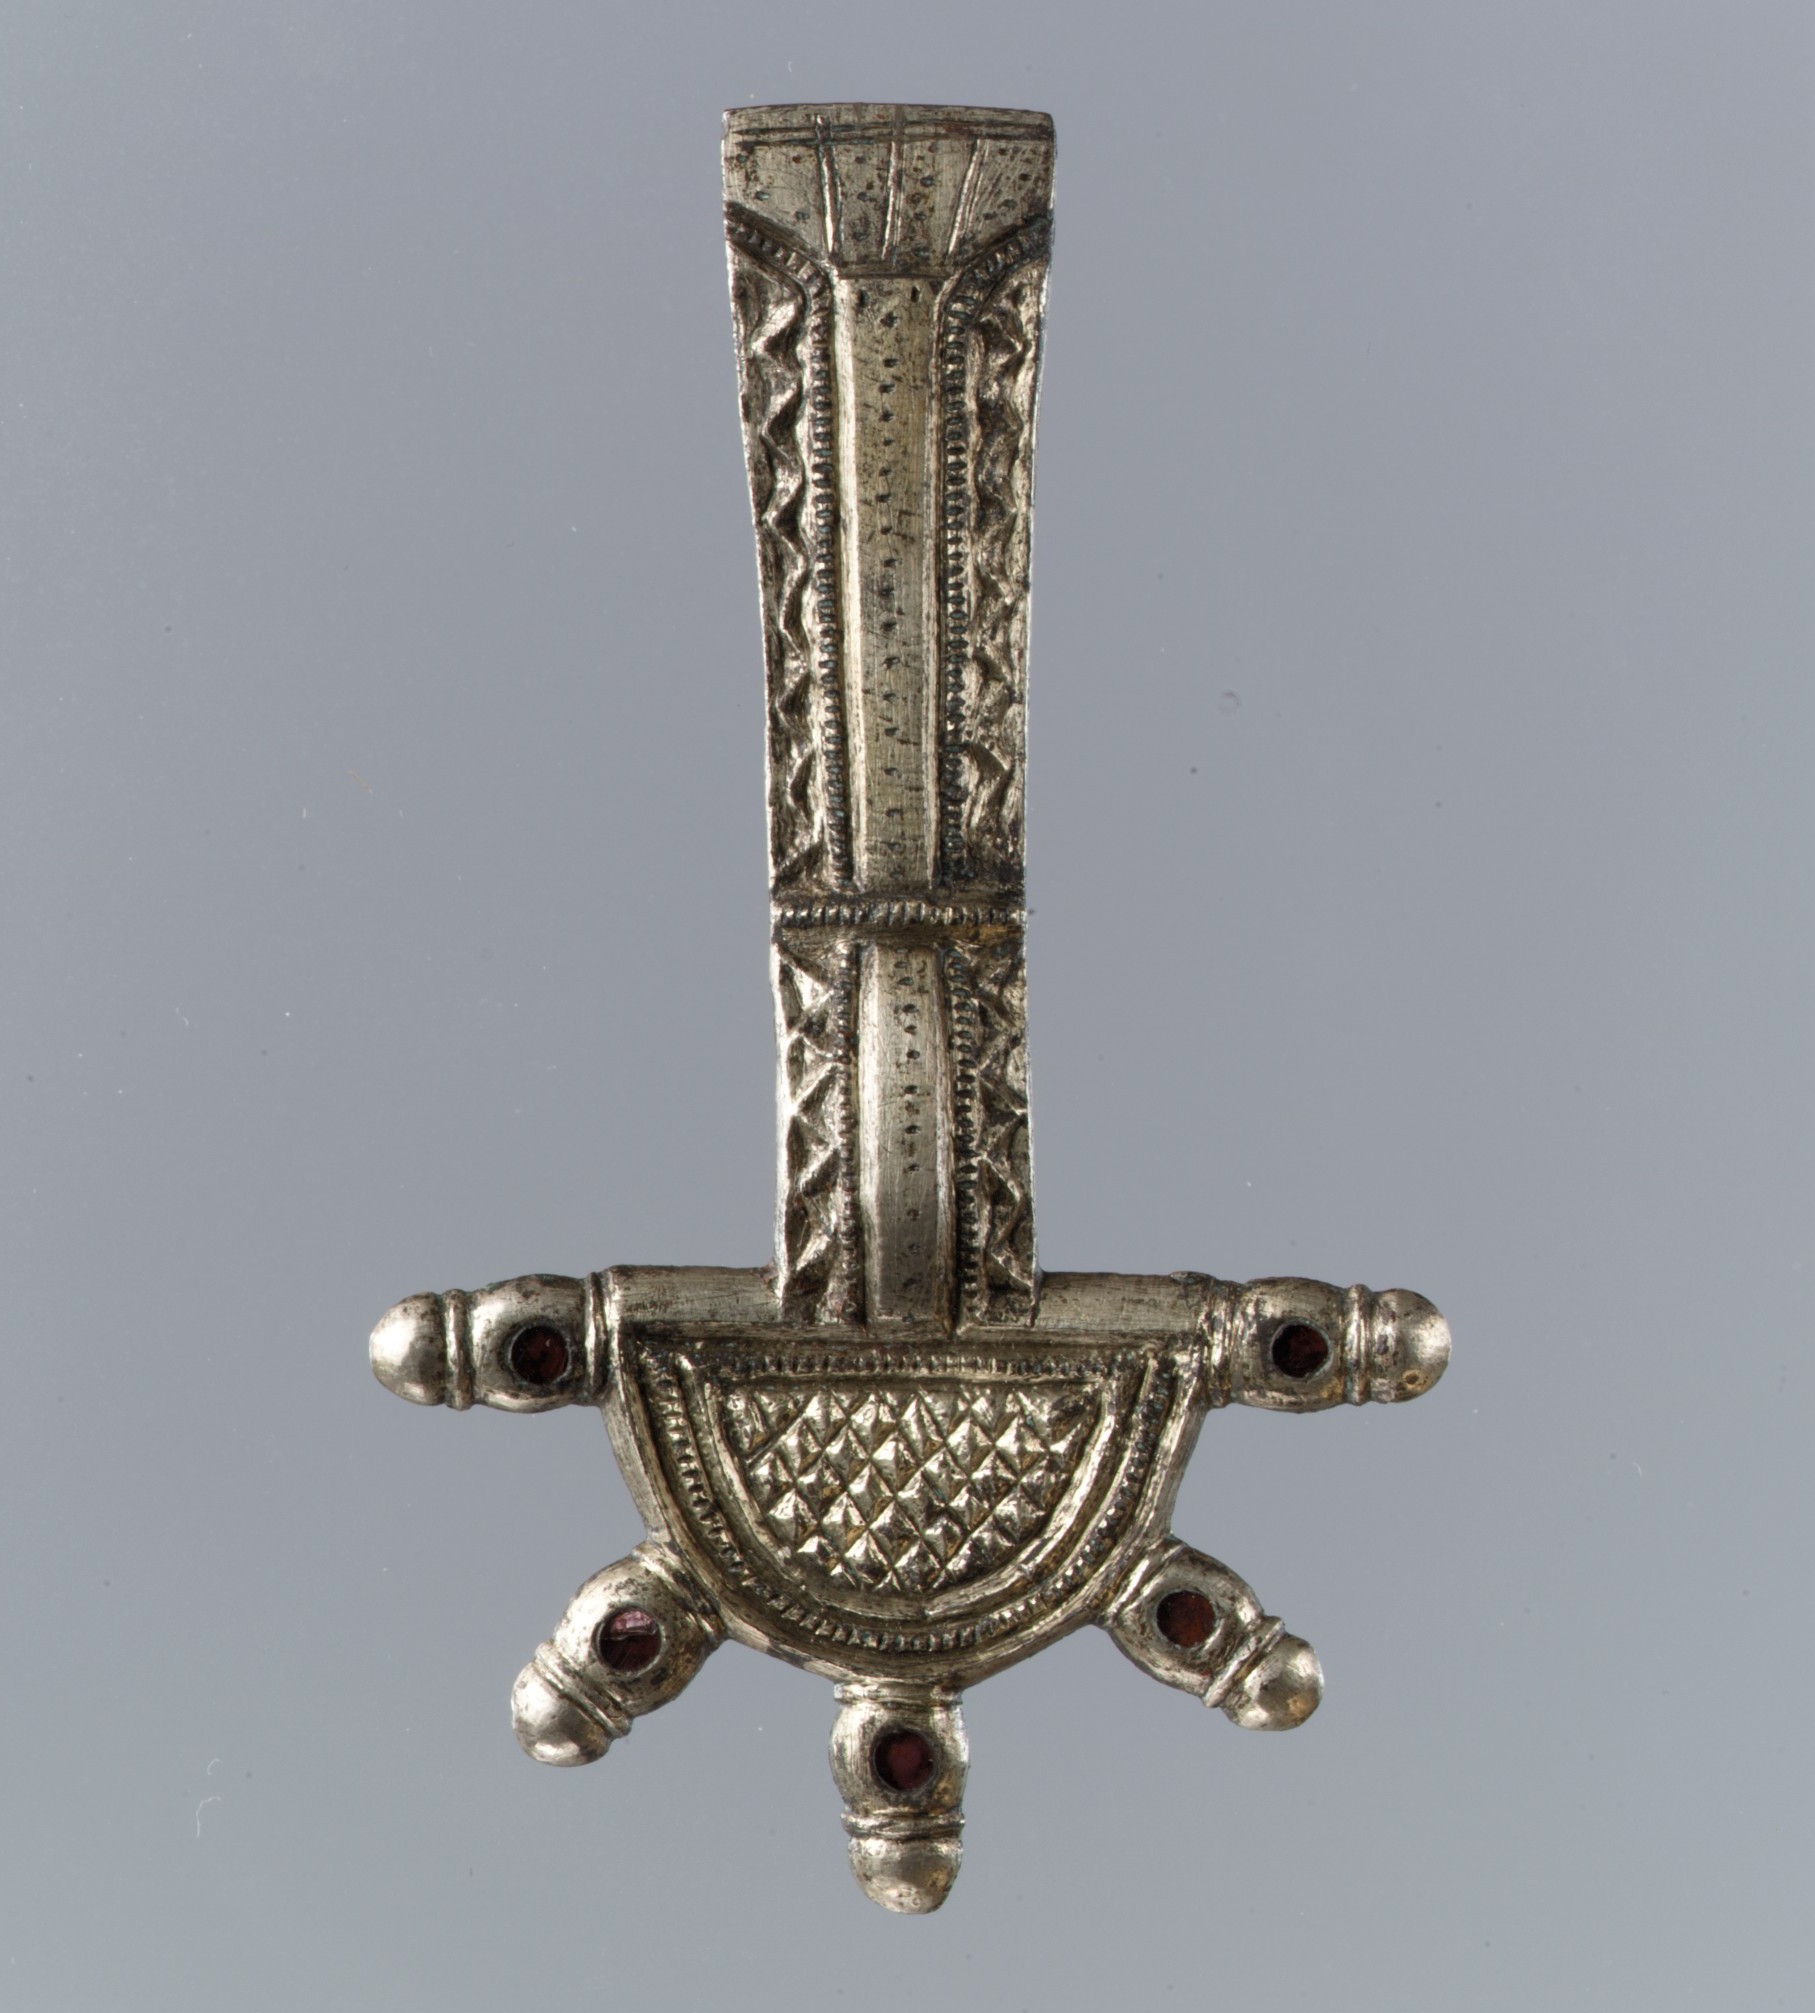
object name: brooch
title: Bow Brooch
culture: frankish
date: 501-550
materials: garnet, silver gilt